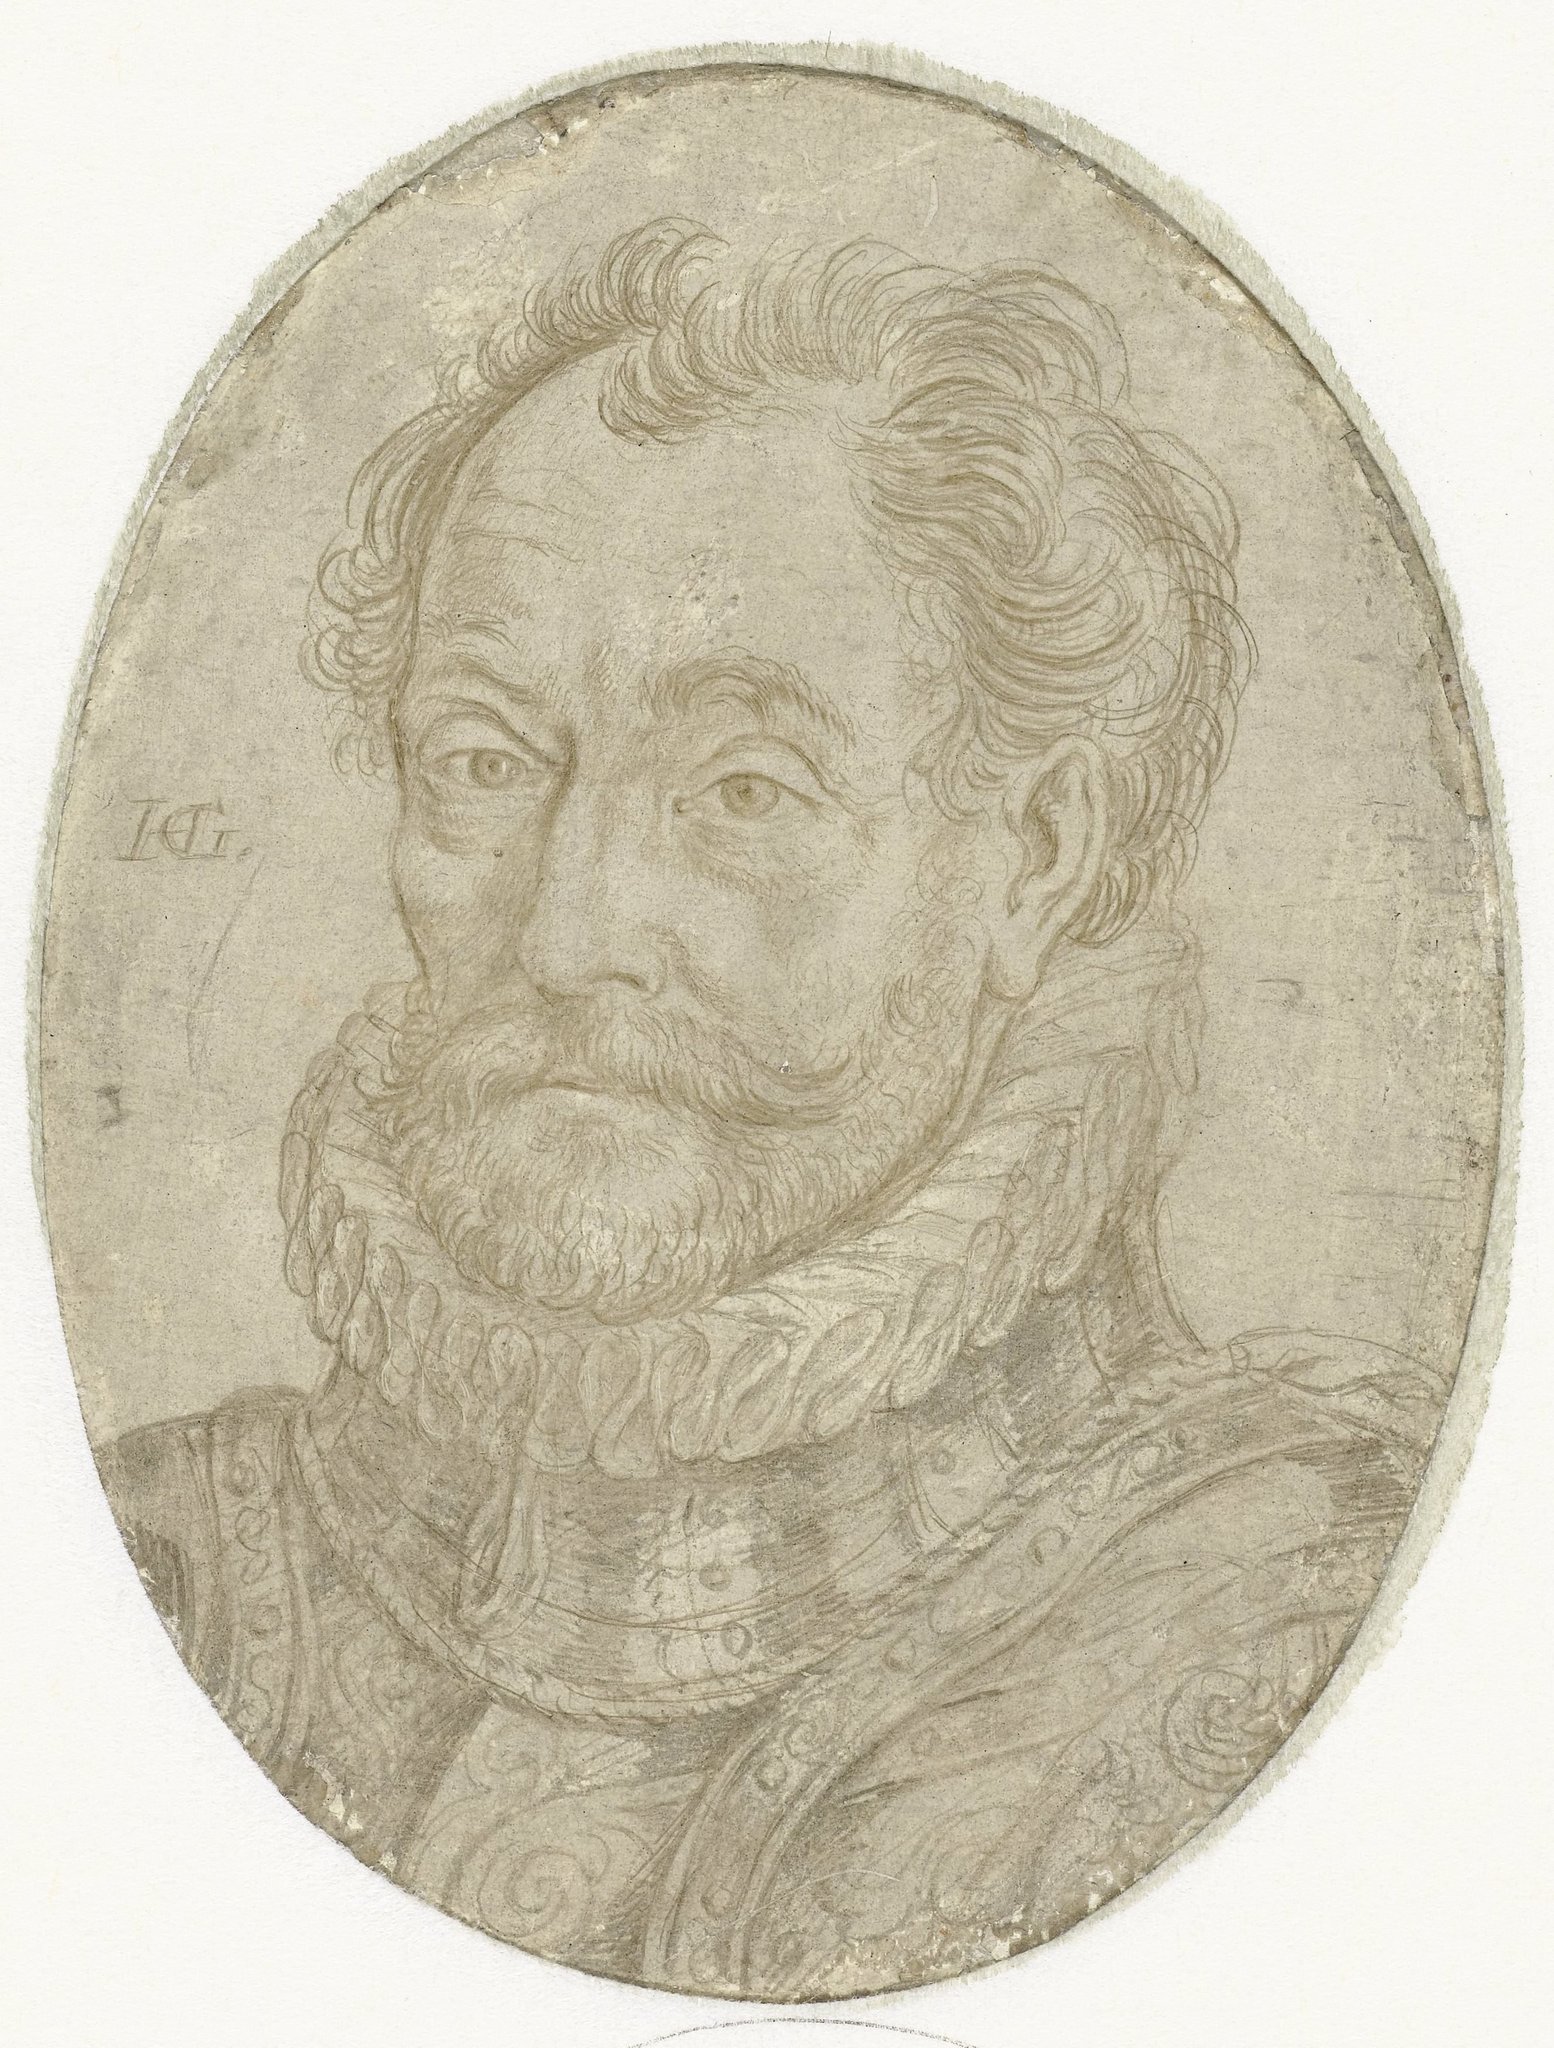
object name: drawing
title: Portret van Prins Willem I van Oranje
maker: hendrick goltzius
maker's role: draughtsman, painter, print maker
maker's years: 1558-1617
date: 1595-1605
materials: paper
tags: delft, william i (prince of orange), historical persons